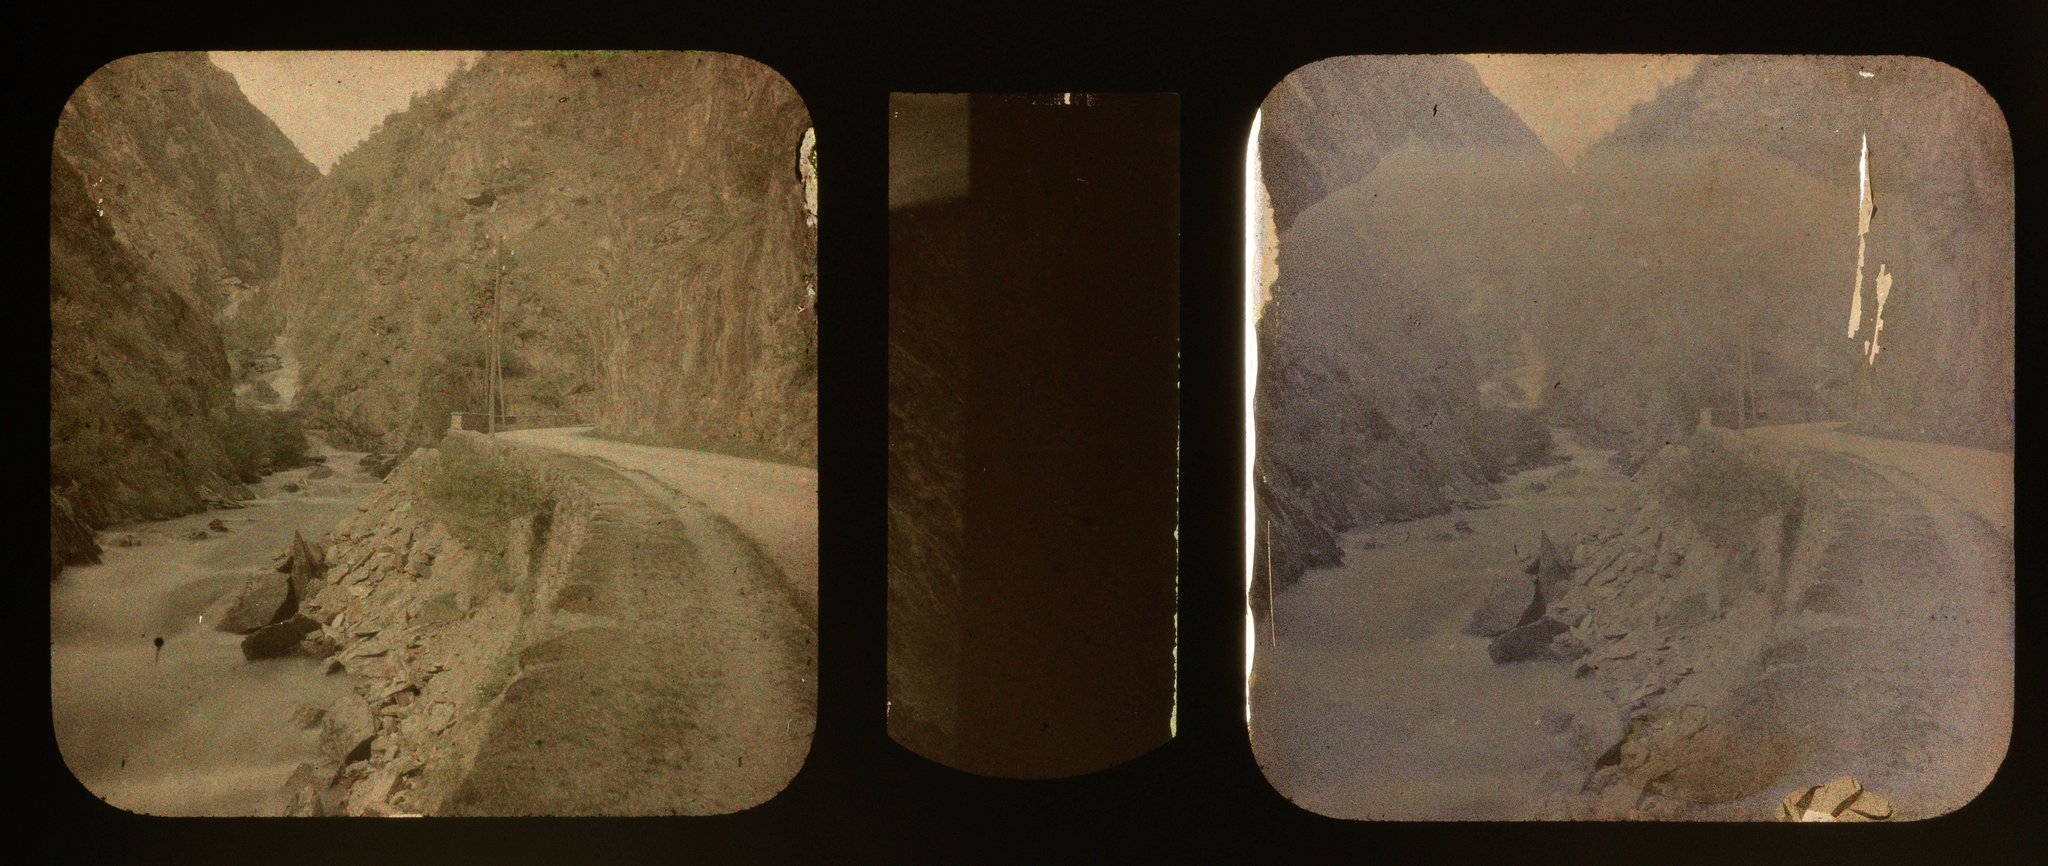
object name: stereoscopic photograph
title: Weg in de bergen naast een beek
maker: adolphe burdet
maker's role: fotograaf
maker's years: 1860-1940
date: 1907-1935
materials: glass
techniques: autochrome process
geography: switzerland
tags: brook, public road, mountains, switzerland